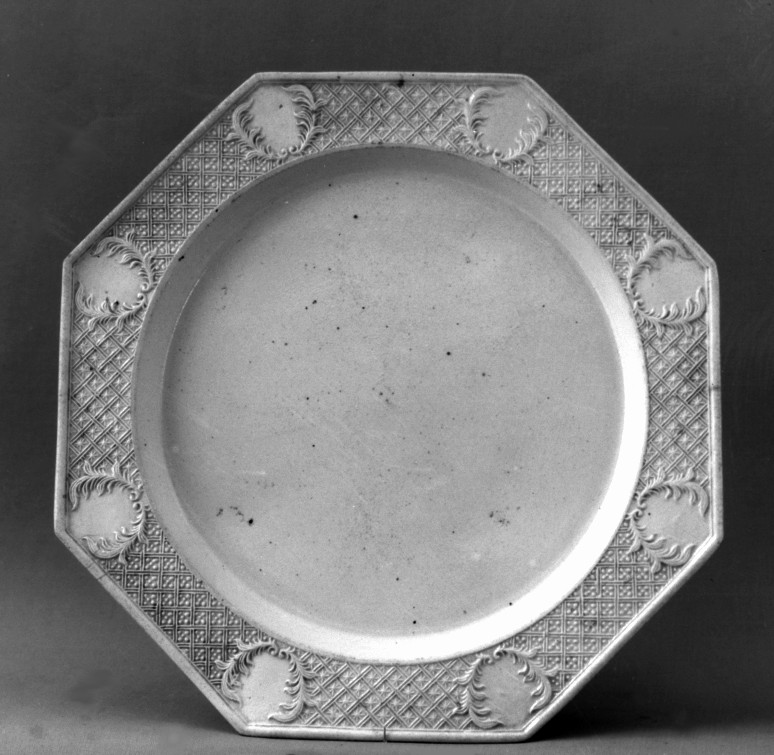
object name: platter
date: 1760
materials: stoneware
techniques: salt glaze